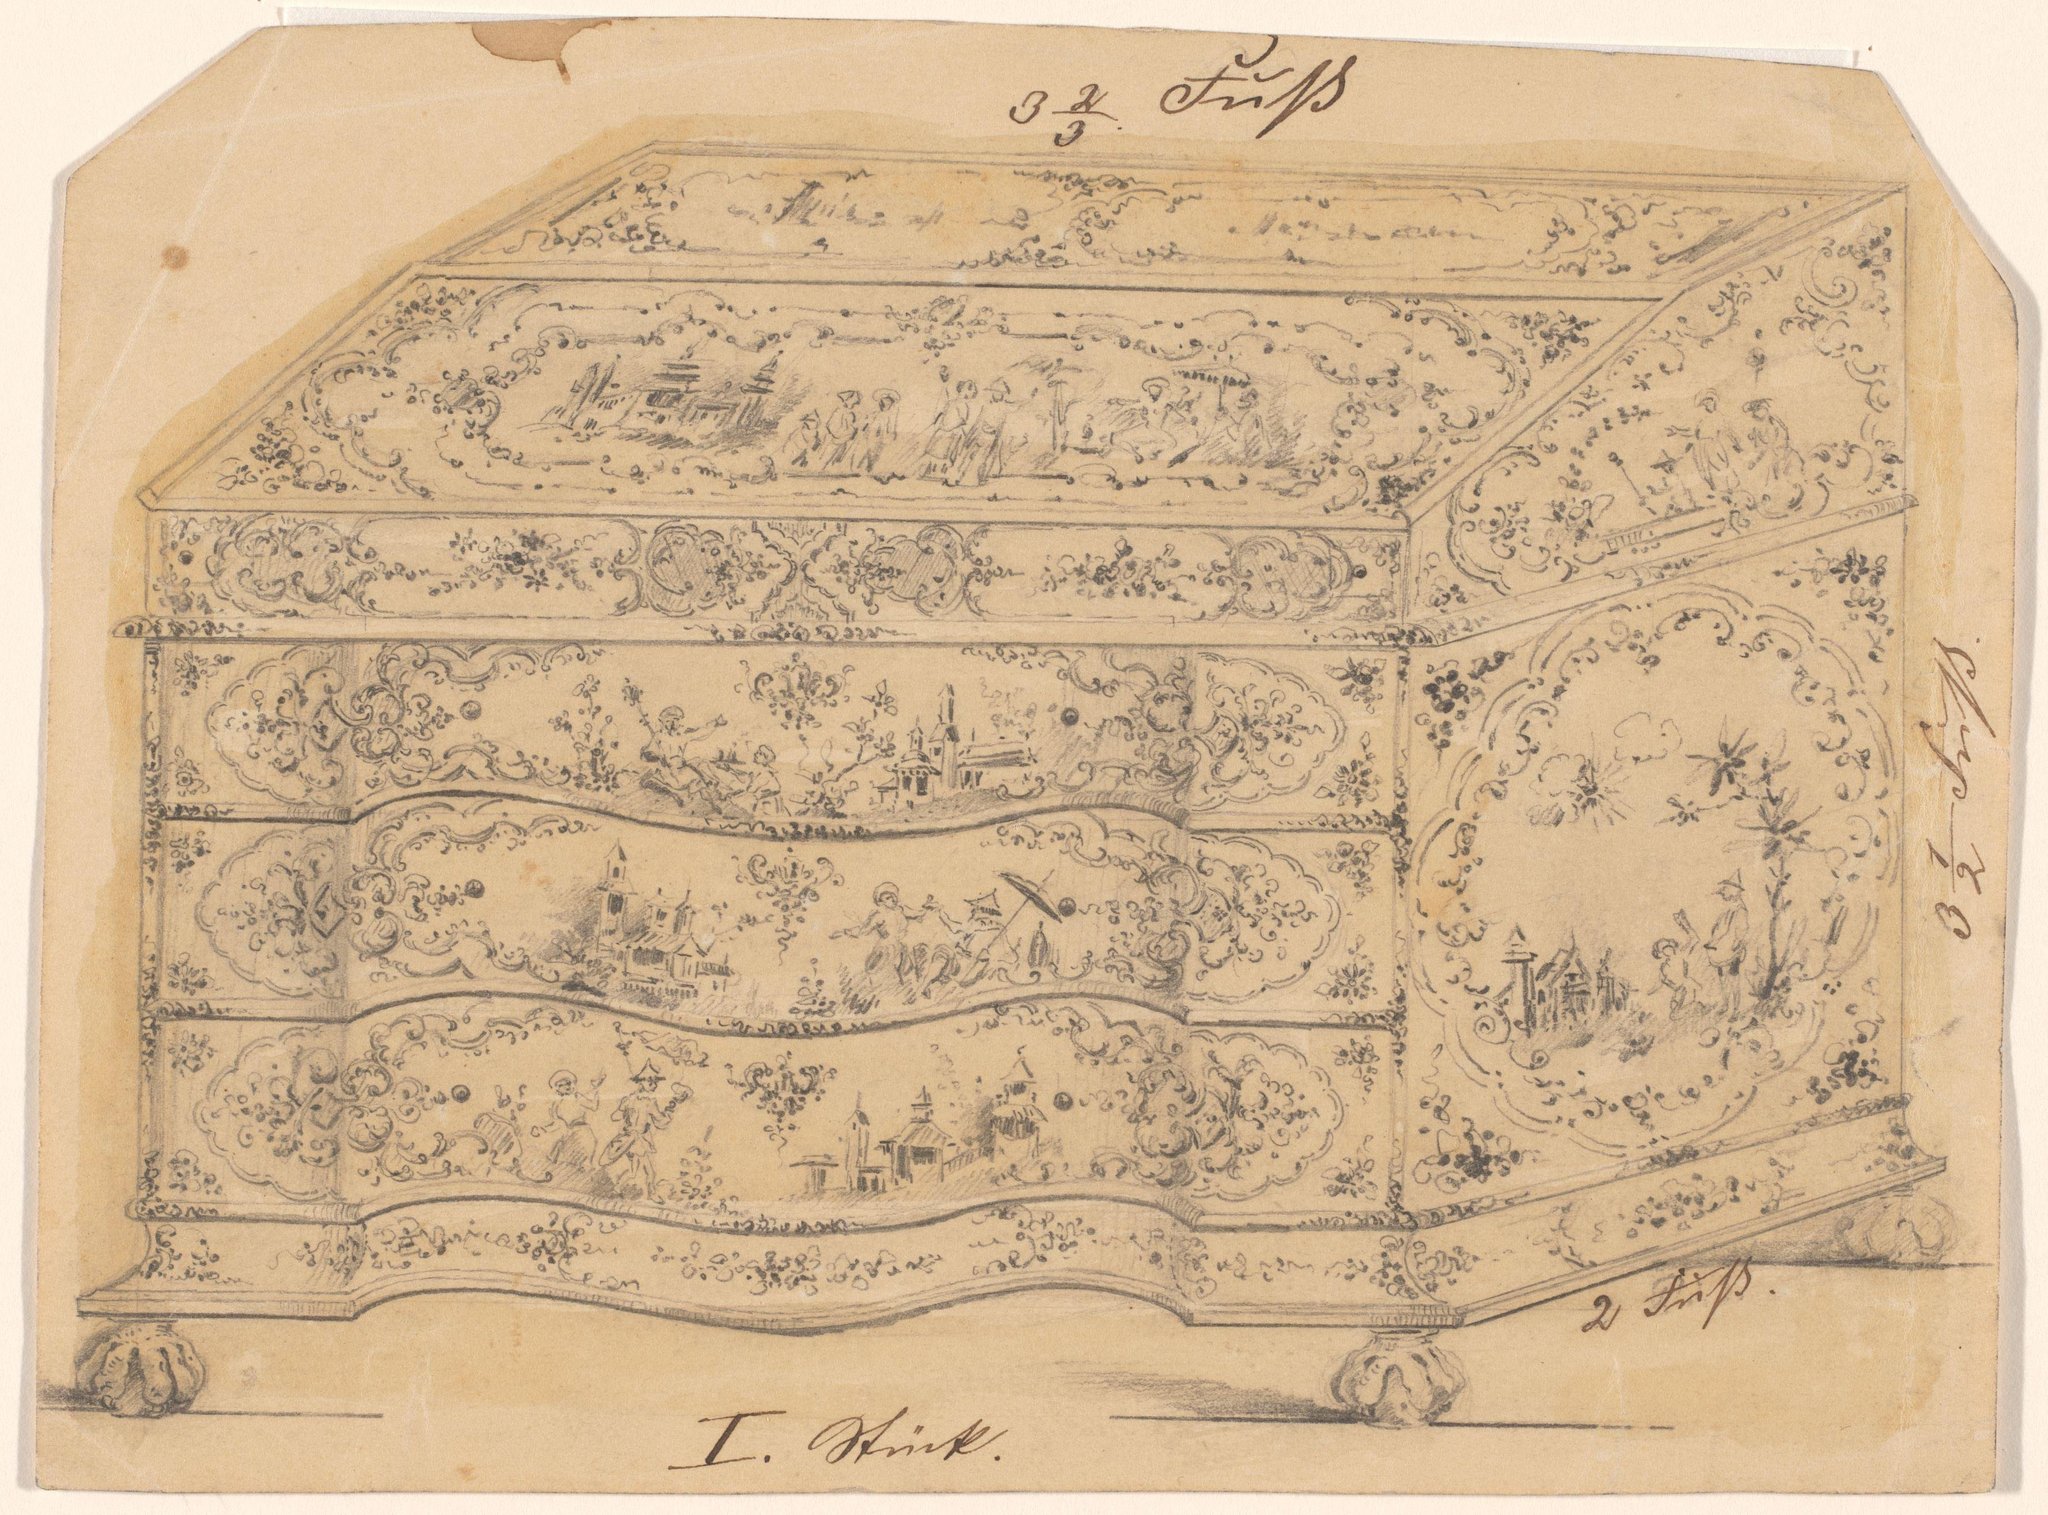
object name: design drawing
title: Bureau met schuine klep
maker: Anonymous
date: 1830-1880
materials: graphite, paper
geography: germany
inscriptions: inscription: ‘3 2/3 Fuss / 3 ½ Fuss. / 2 Fuss. / I. Stück’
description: Bureau versierd met chinoiserie-voorstellingen, waarschijnlijk in lakwerk.